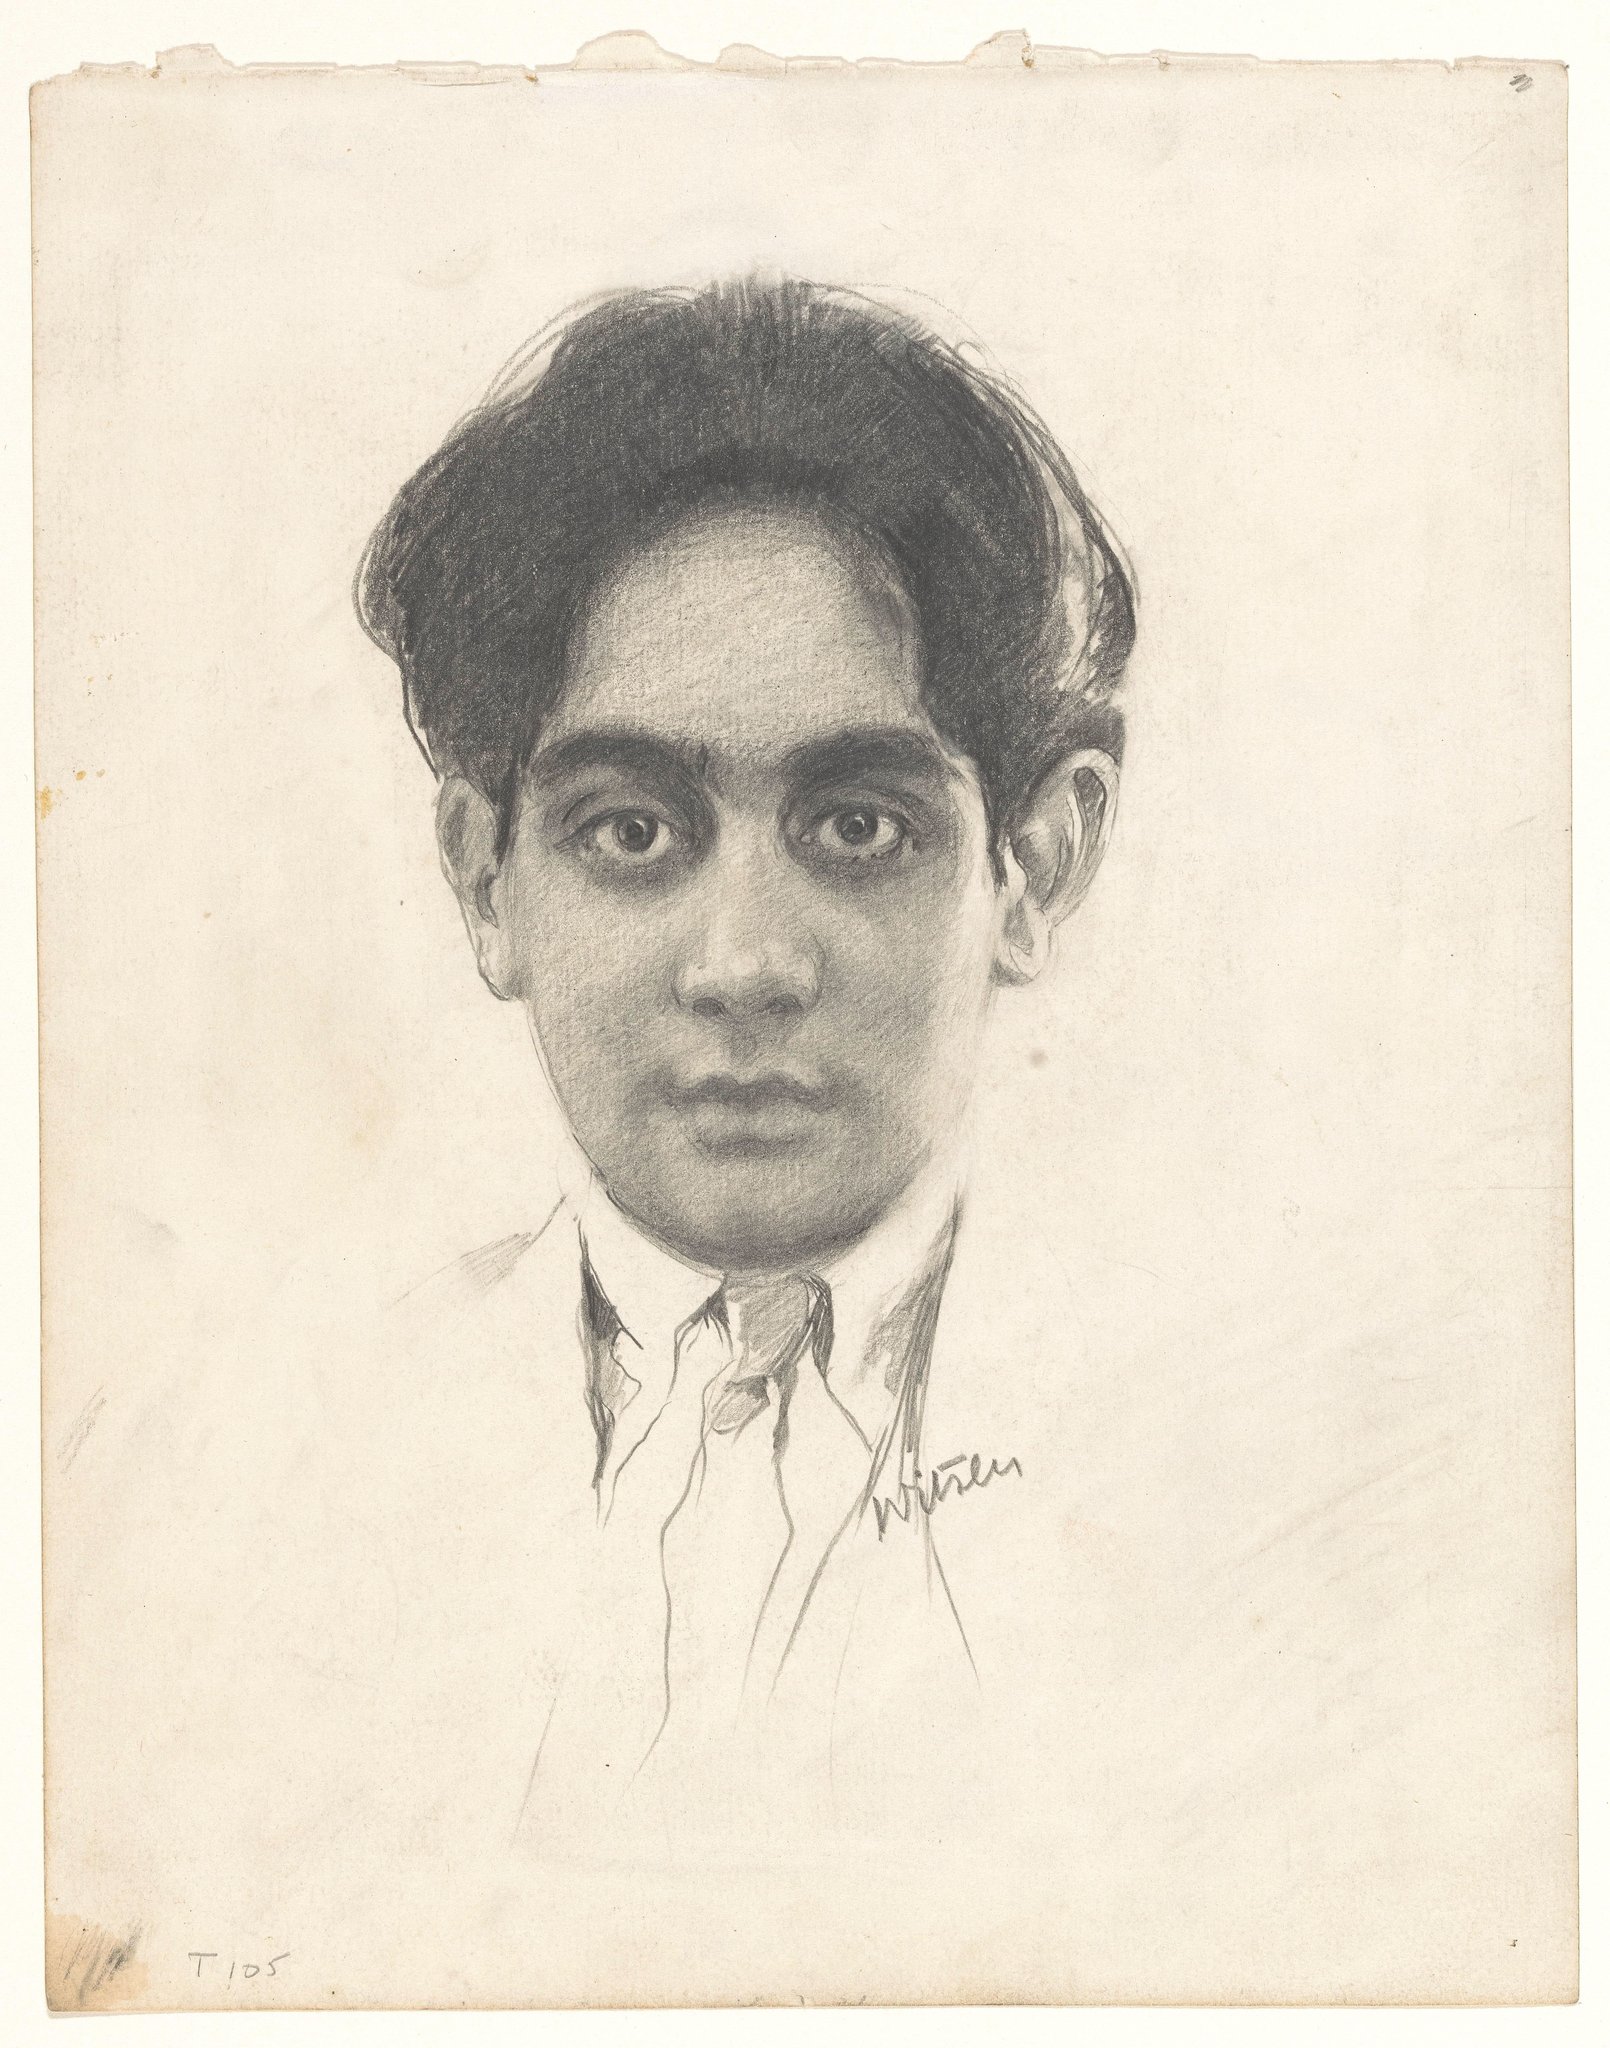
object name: drawing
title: Portret van Karamjit Singh Sahib Bahadur, prins van Kapurthala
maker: willem witsen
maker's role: draughtsman, painter, print maker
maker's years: 1860-1923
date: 1915-1916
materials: paper, pencil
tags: politician, historical persons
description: Voor schilderij van de geportretteerde door Witsen, zie collectie Dordrechts Museum (bruikleen RCE).